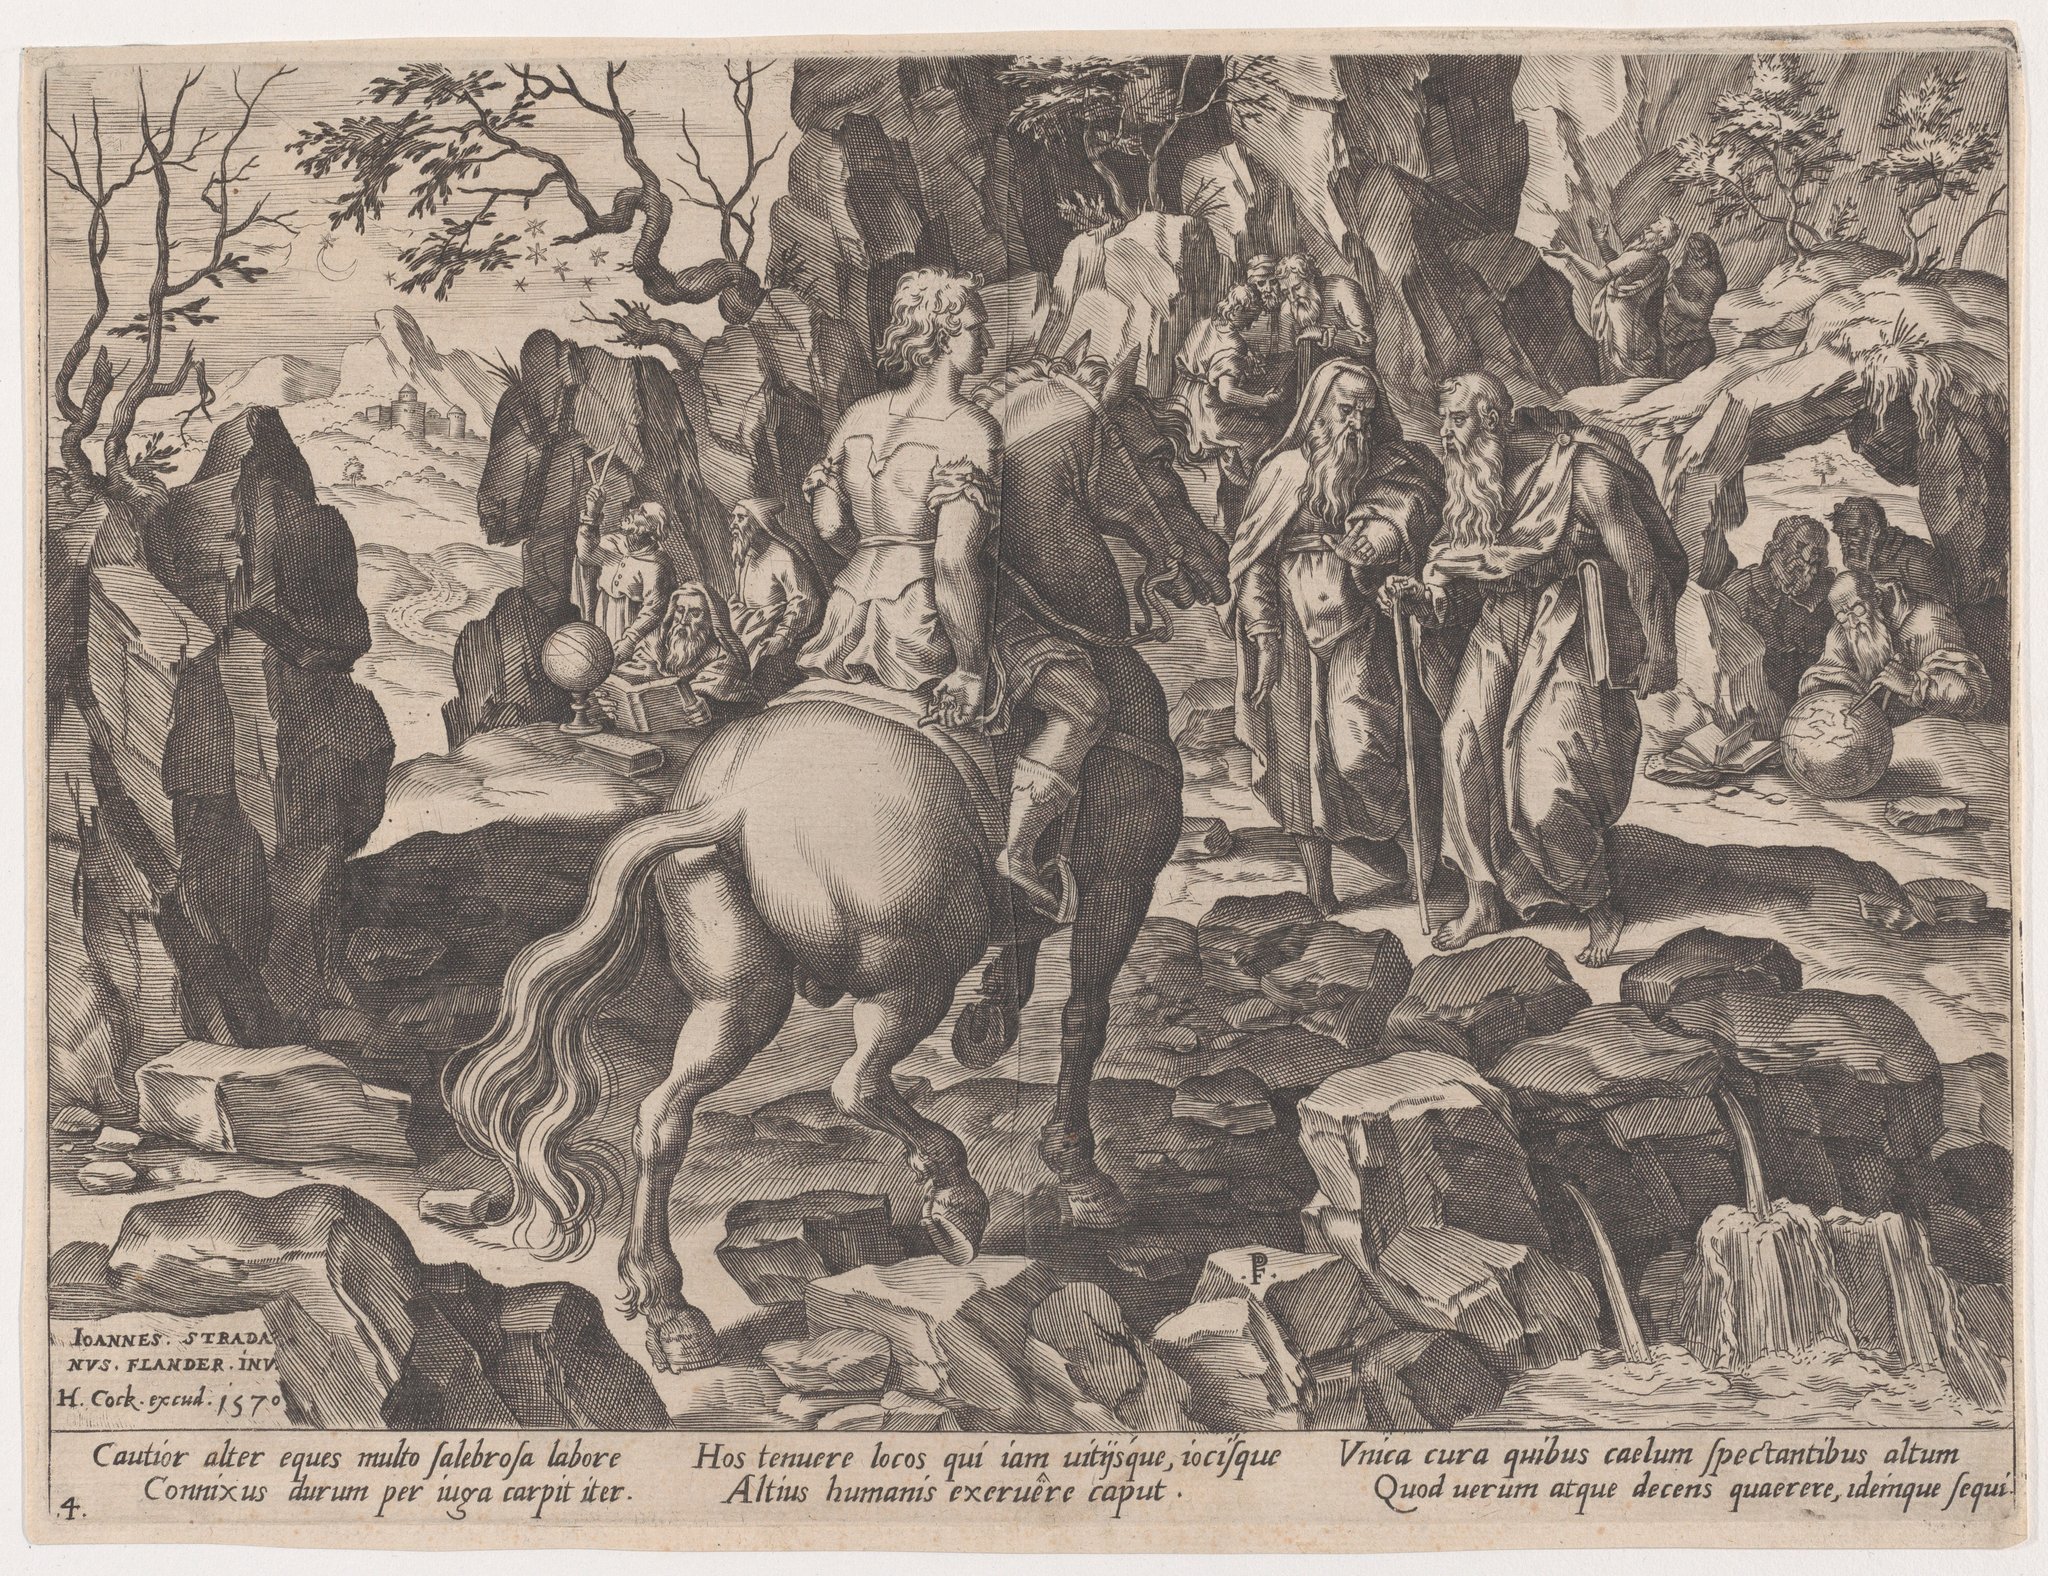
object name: print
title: Amassing Knowledge, from "The Course of Human Life"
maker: pieter jalhea furnius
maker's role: artist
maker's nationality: flemish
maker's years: 1545-1610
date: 1570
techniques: engraving